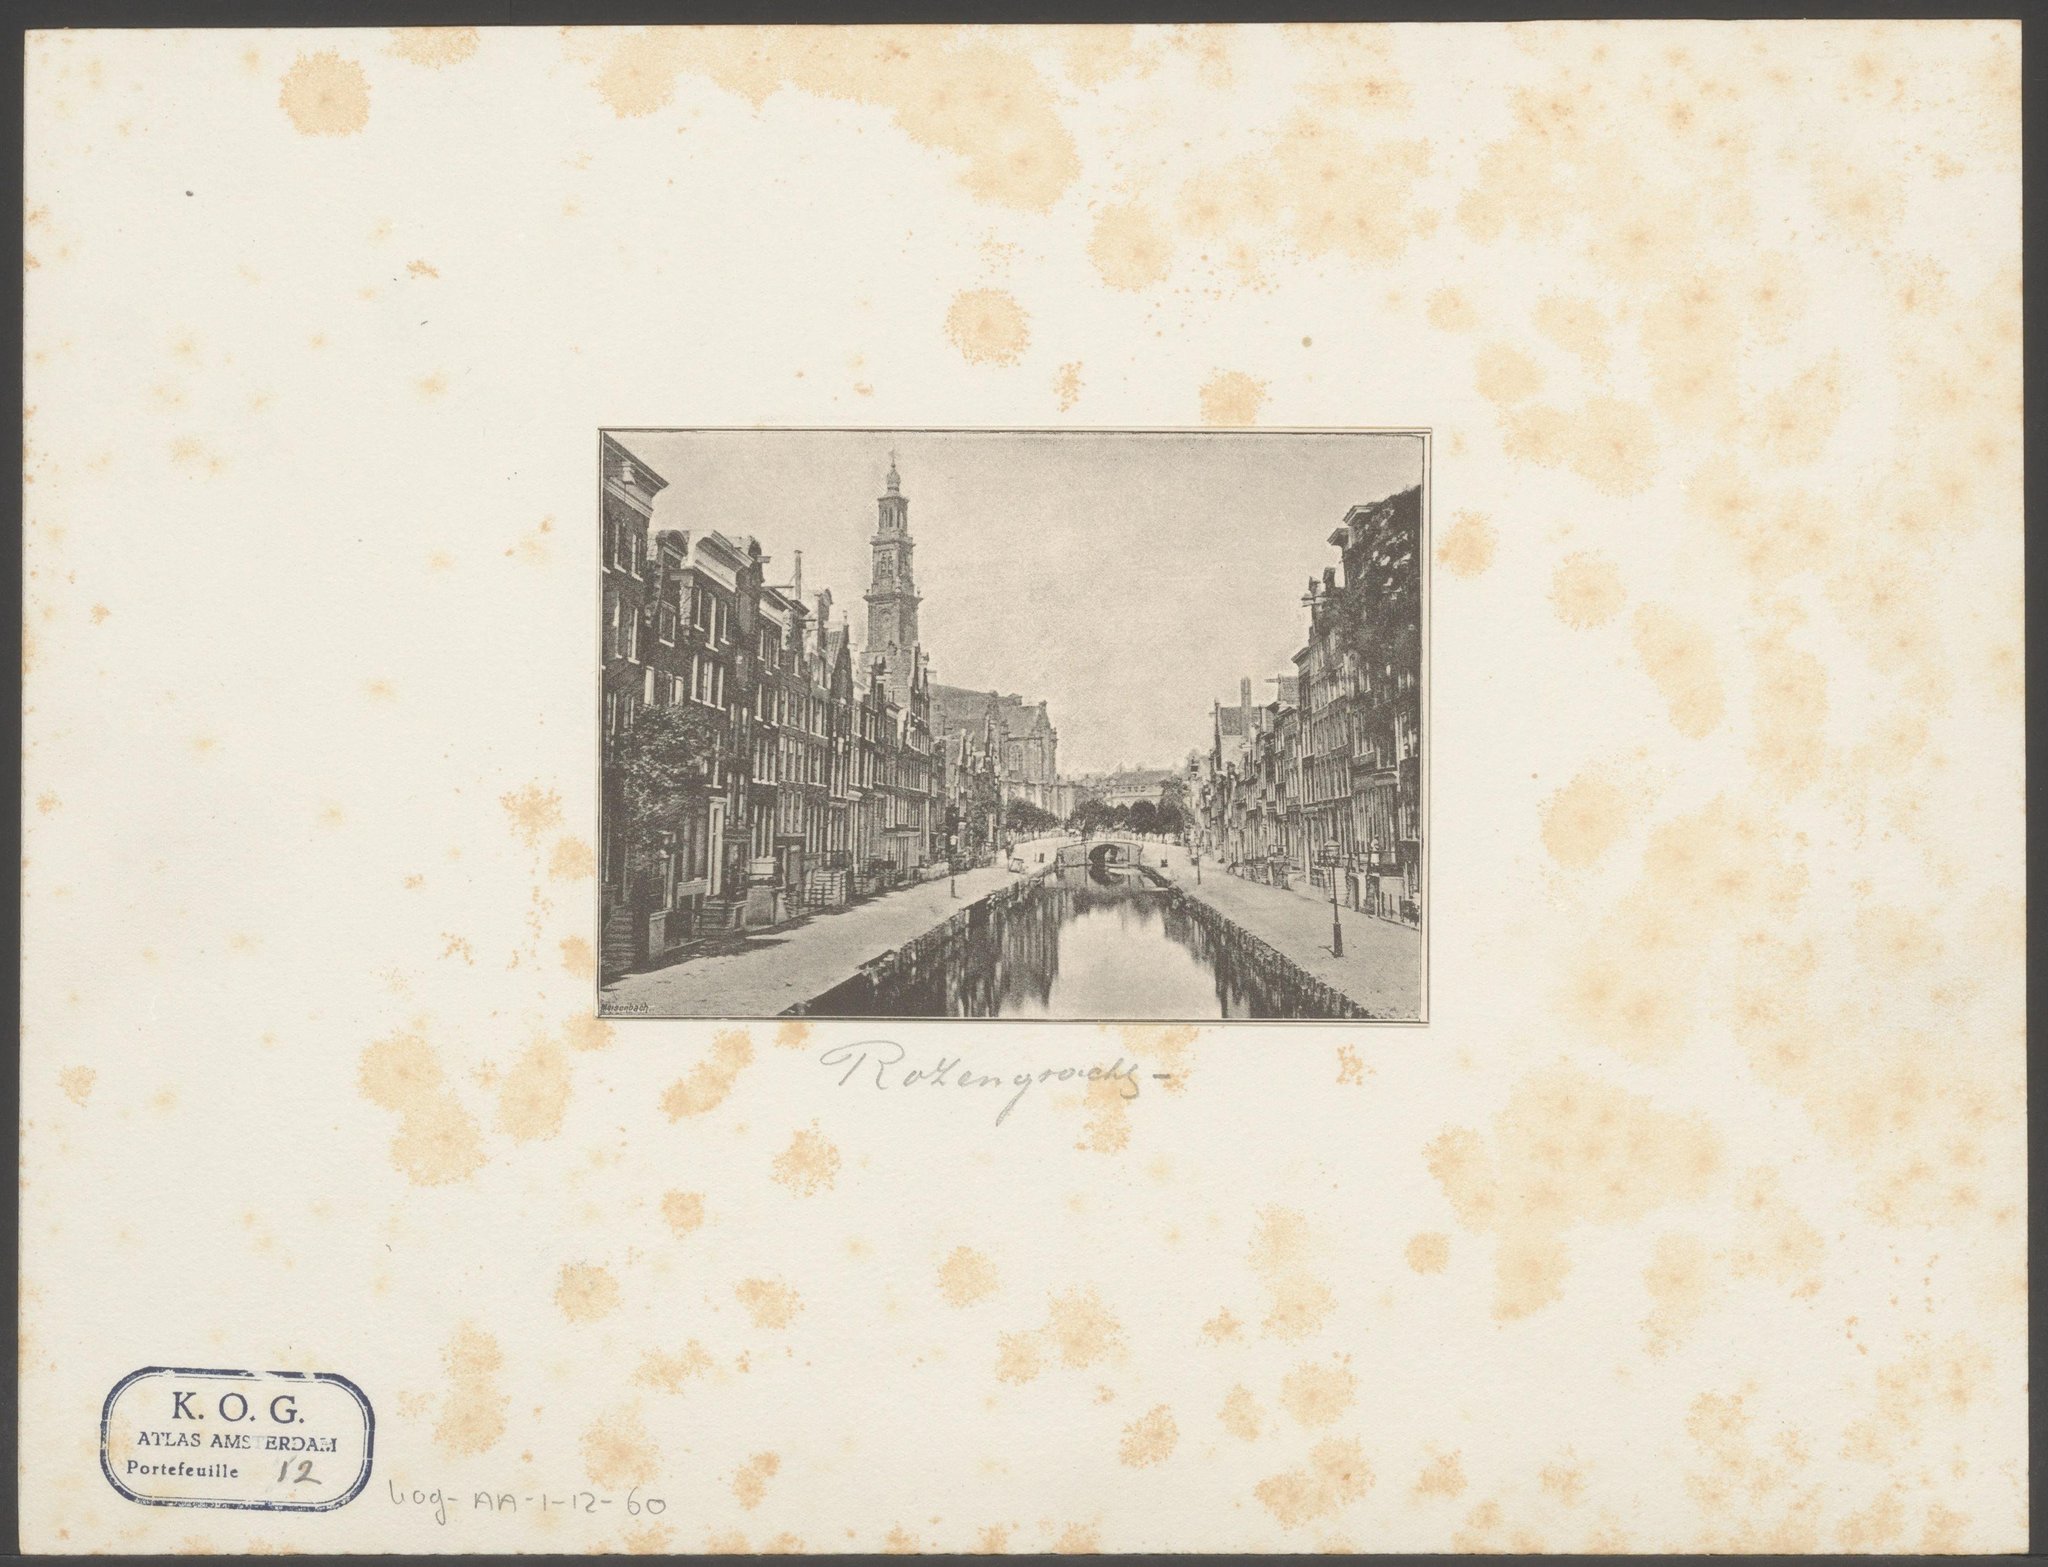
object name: photomechanical print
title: Gezicht op de Rozengracht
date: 1882-1950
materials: cardboard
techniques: autotype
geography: amsterdam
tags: tower, clock tower ~ monumental adornment, city-view in general; 'veduta', canal, the usual house or row of houses, bridge in city across river, canal, etc.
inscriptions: collector's mark: ‘12’ Lugt 1641b, inscription: ‘Rozengracht-’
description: Onderwerpsrubriek binnen de Atlas Amsterdam: Rokin, Rotterdammersloot, Rozengang, Rozengracht, Rozenstraat, Rusland, Rustenburgerstraat, Ruysdaelkade, Ruysdaelstraat, Ruyterkade (de), Ruyterweg (Admiraal de).